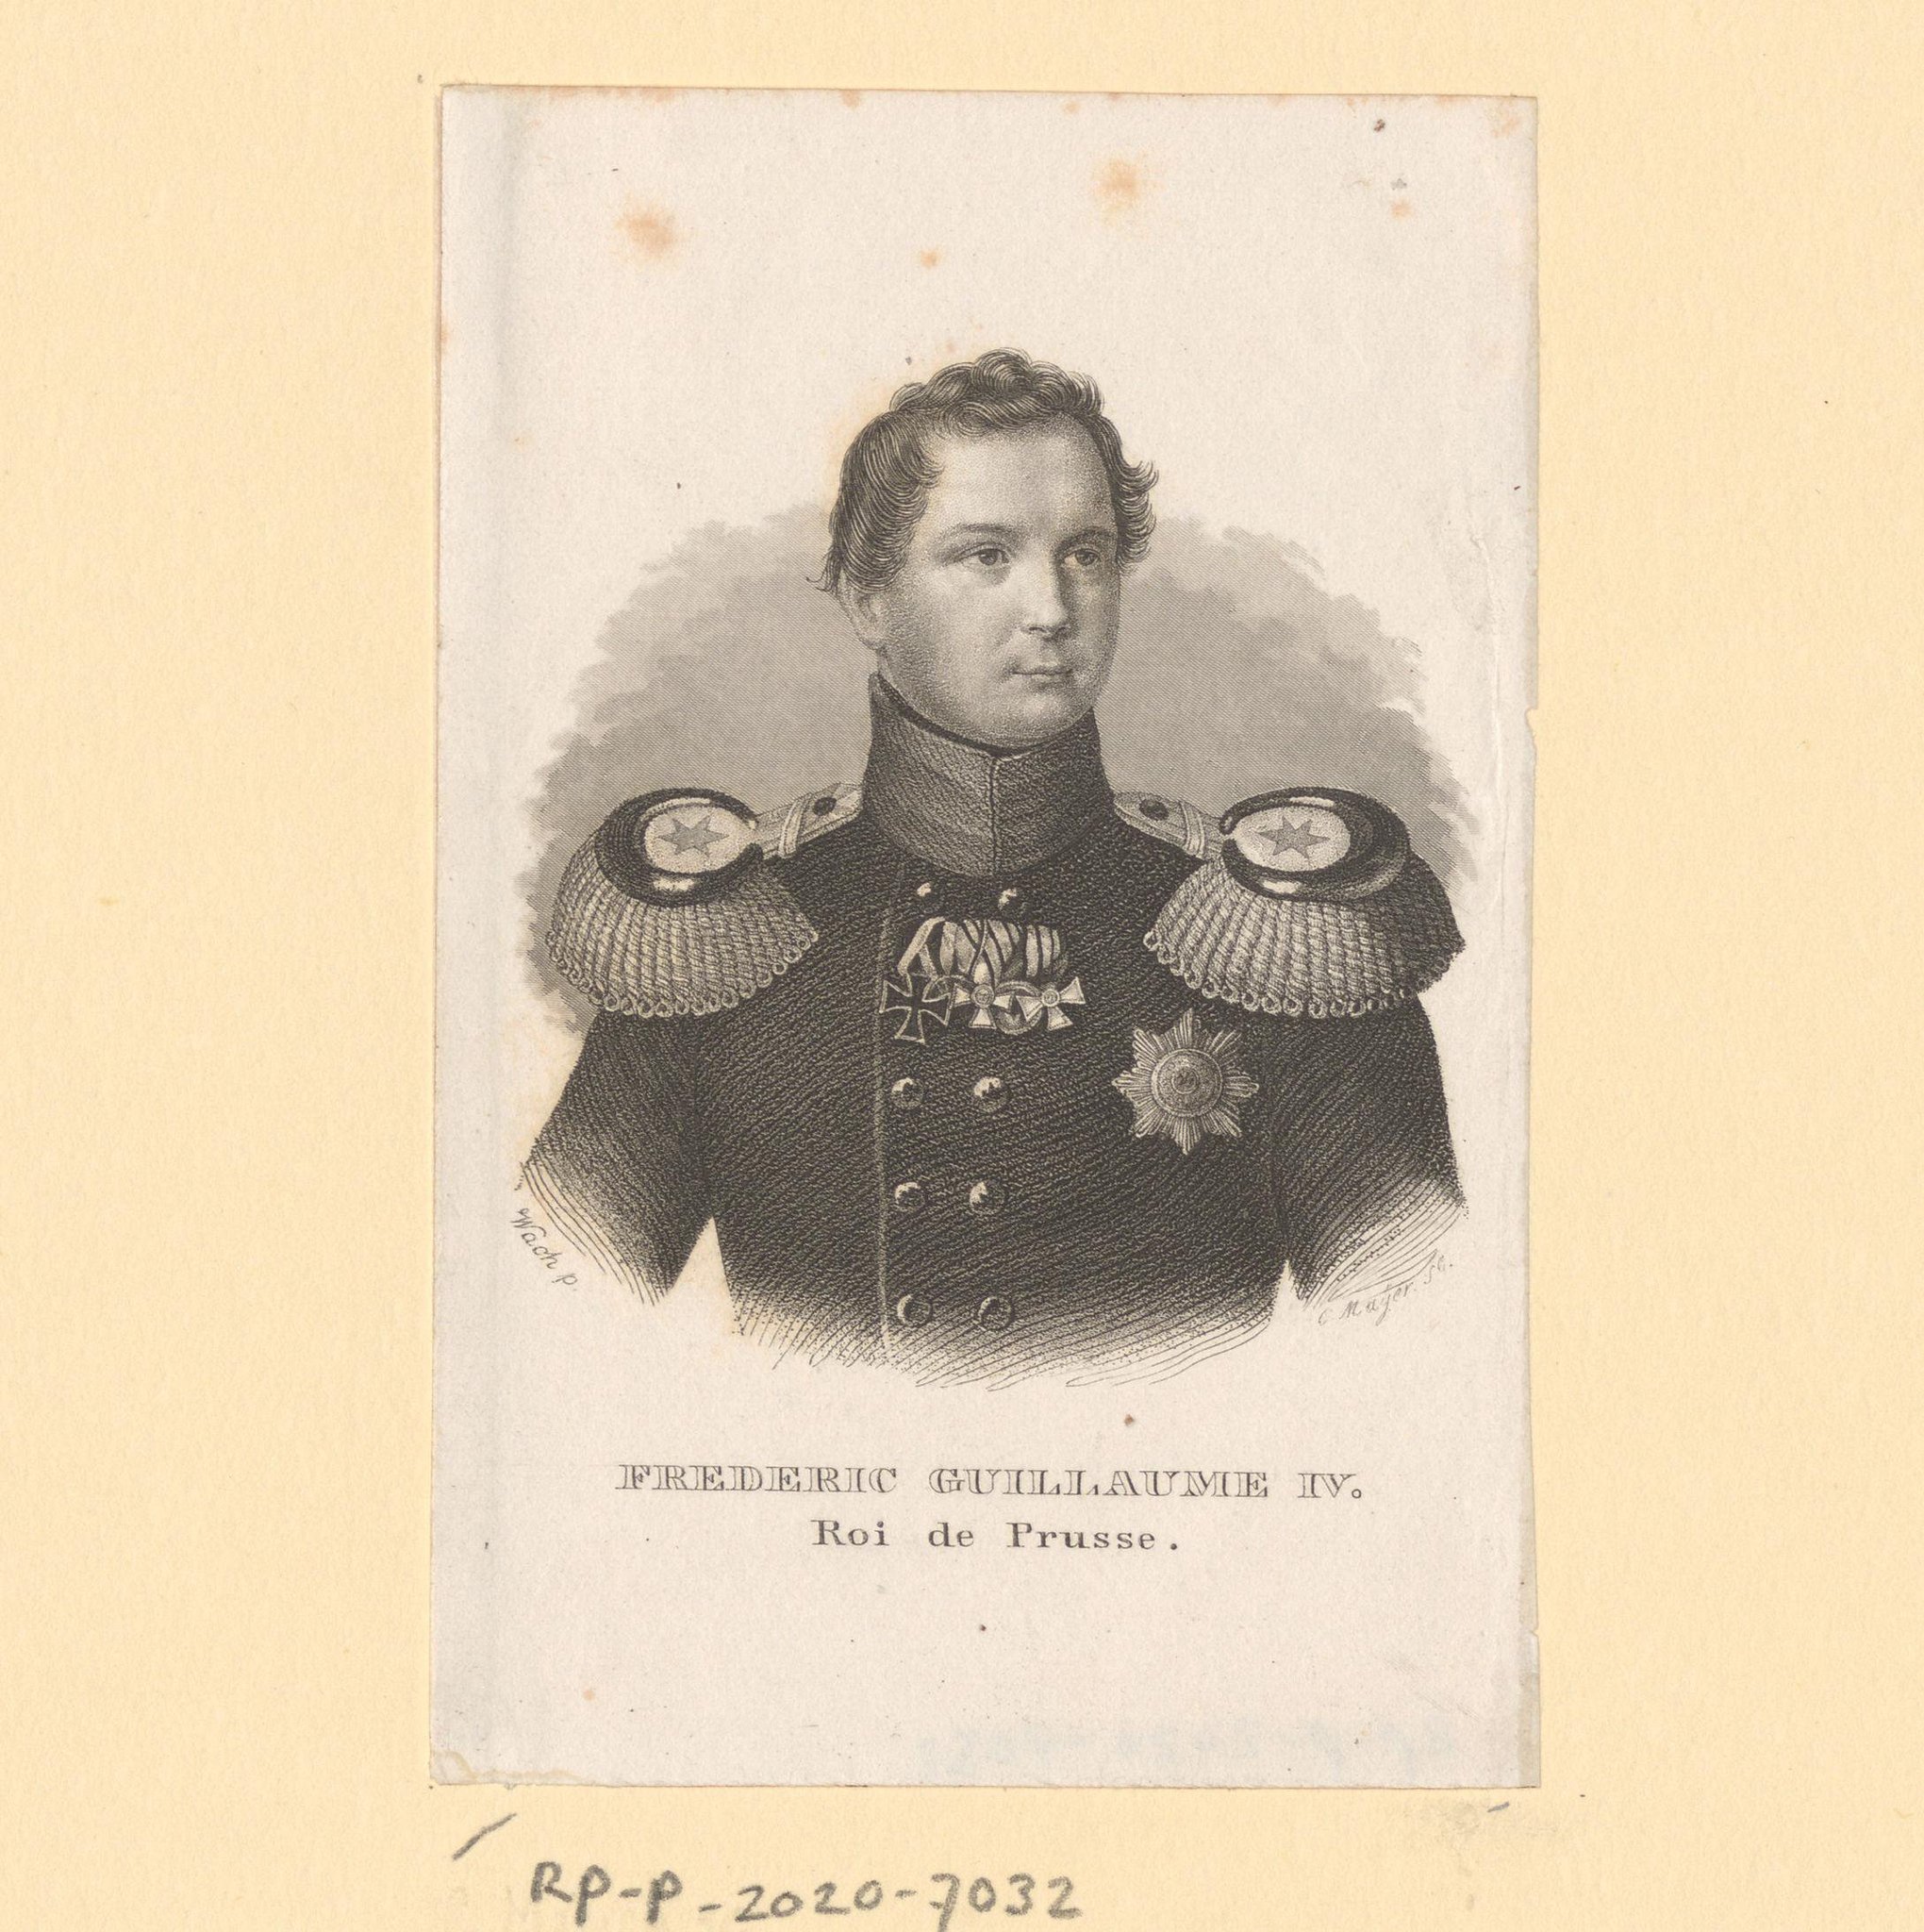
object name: print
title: Portret van Frederik Willem IV van Pruisen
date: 1840-1868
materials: paper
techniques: etching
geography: nuremberg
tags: berlin, frederik willem iv (koning van pruisen), historical persons, (military) uniforms, king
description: Prent komt mogelijk uit een editie van 'Almanach de Gotha'.